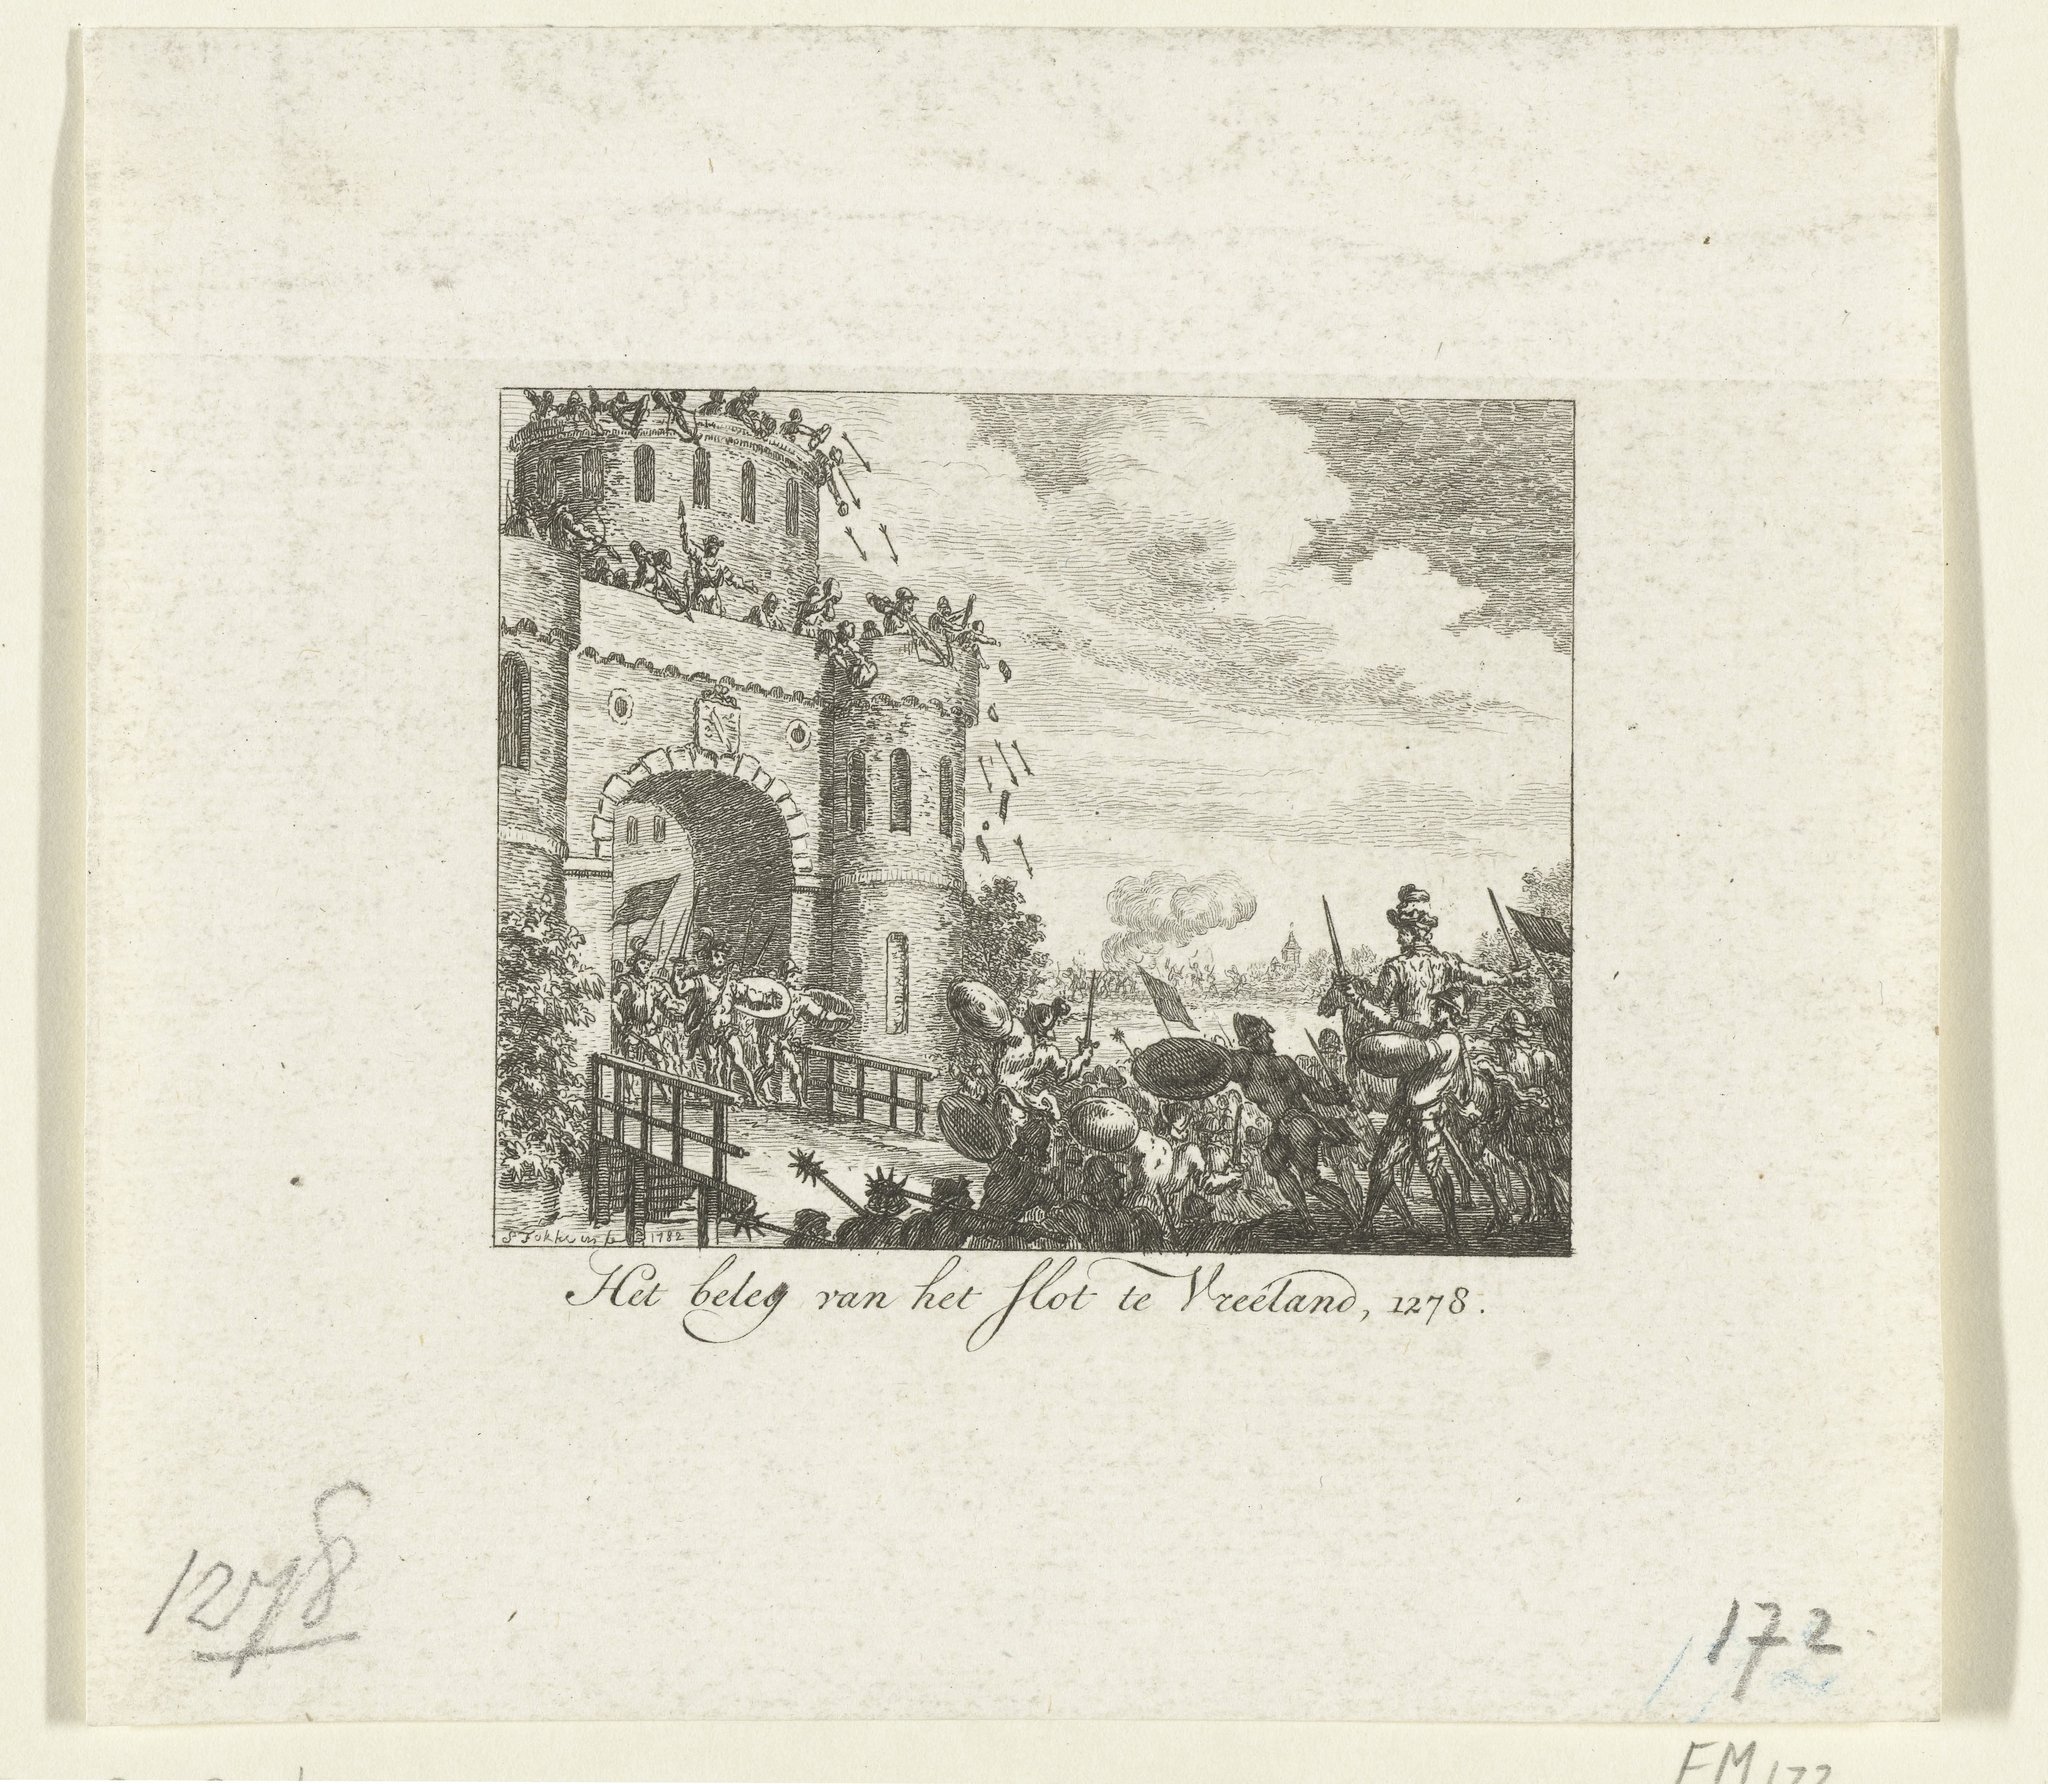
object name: history print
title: Beleg van het slot Vreeland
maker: simon fokke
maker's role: draughtsman, print maker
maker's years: 1712-1784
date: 1782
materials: paper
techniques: etching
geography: northern netherlands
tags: leiden, floris v (graaf van holland en zeeland), siege, position war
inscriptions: date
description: Illustratie voor: J.W. te Water, De vaderlandsche Historie van den heere J. Wagenaar, verkort, en met leerzaame aanmerkingen, ten dienste der Nederlandsche jeugd, 1784-1800, 4 delen. Volgens de catalogus van de Atlas van Stolk onderdeel van een serie van 7 prentjes van straatoproer te Amsterdam, in 1781 verschenen.